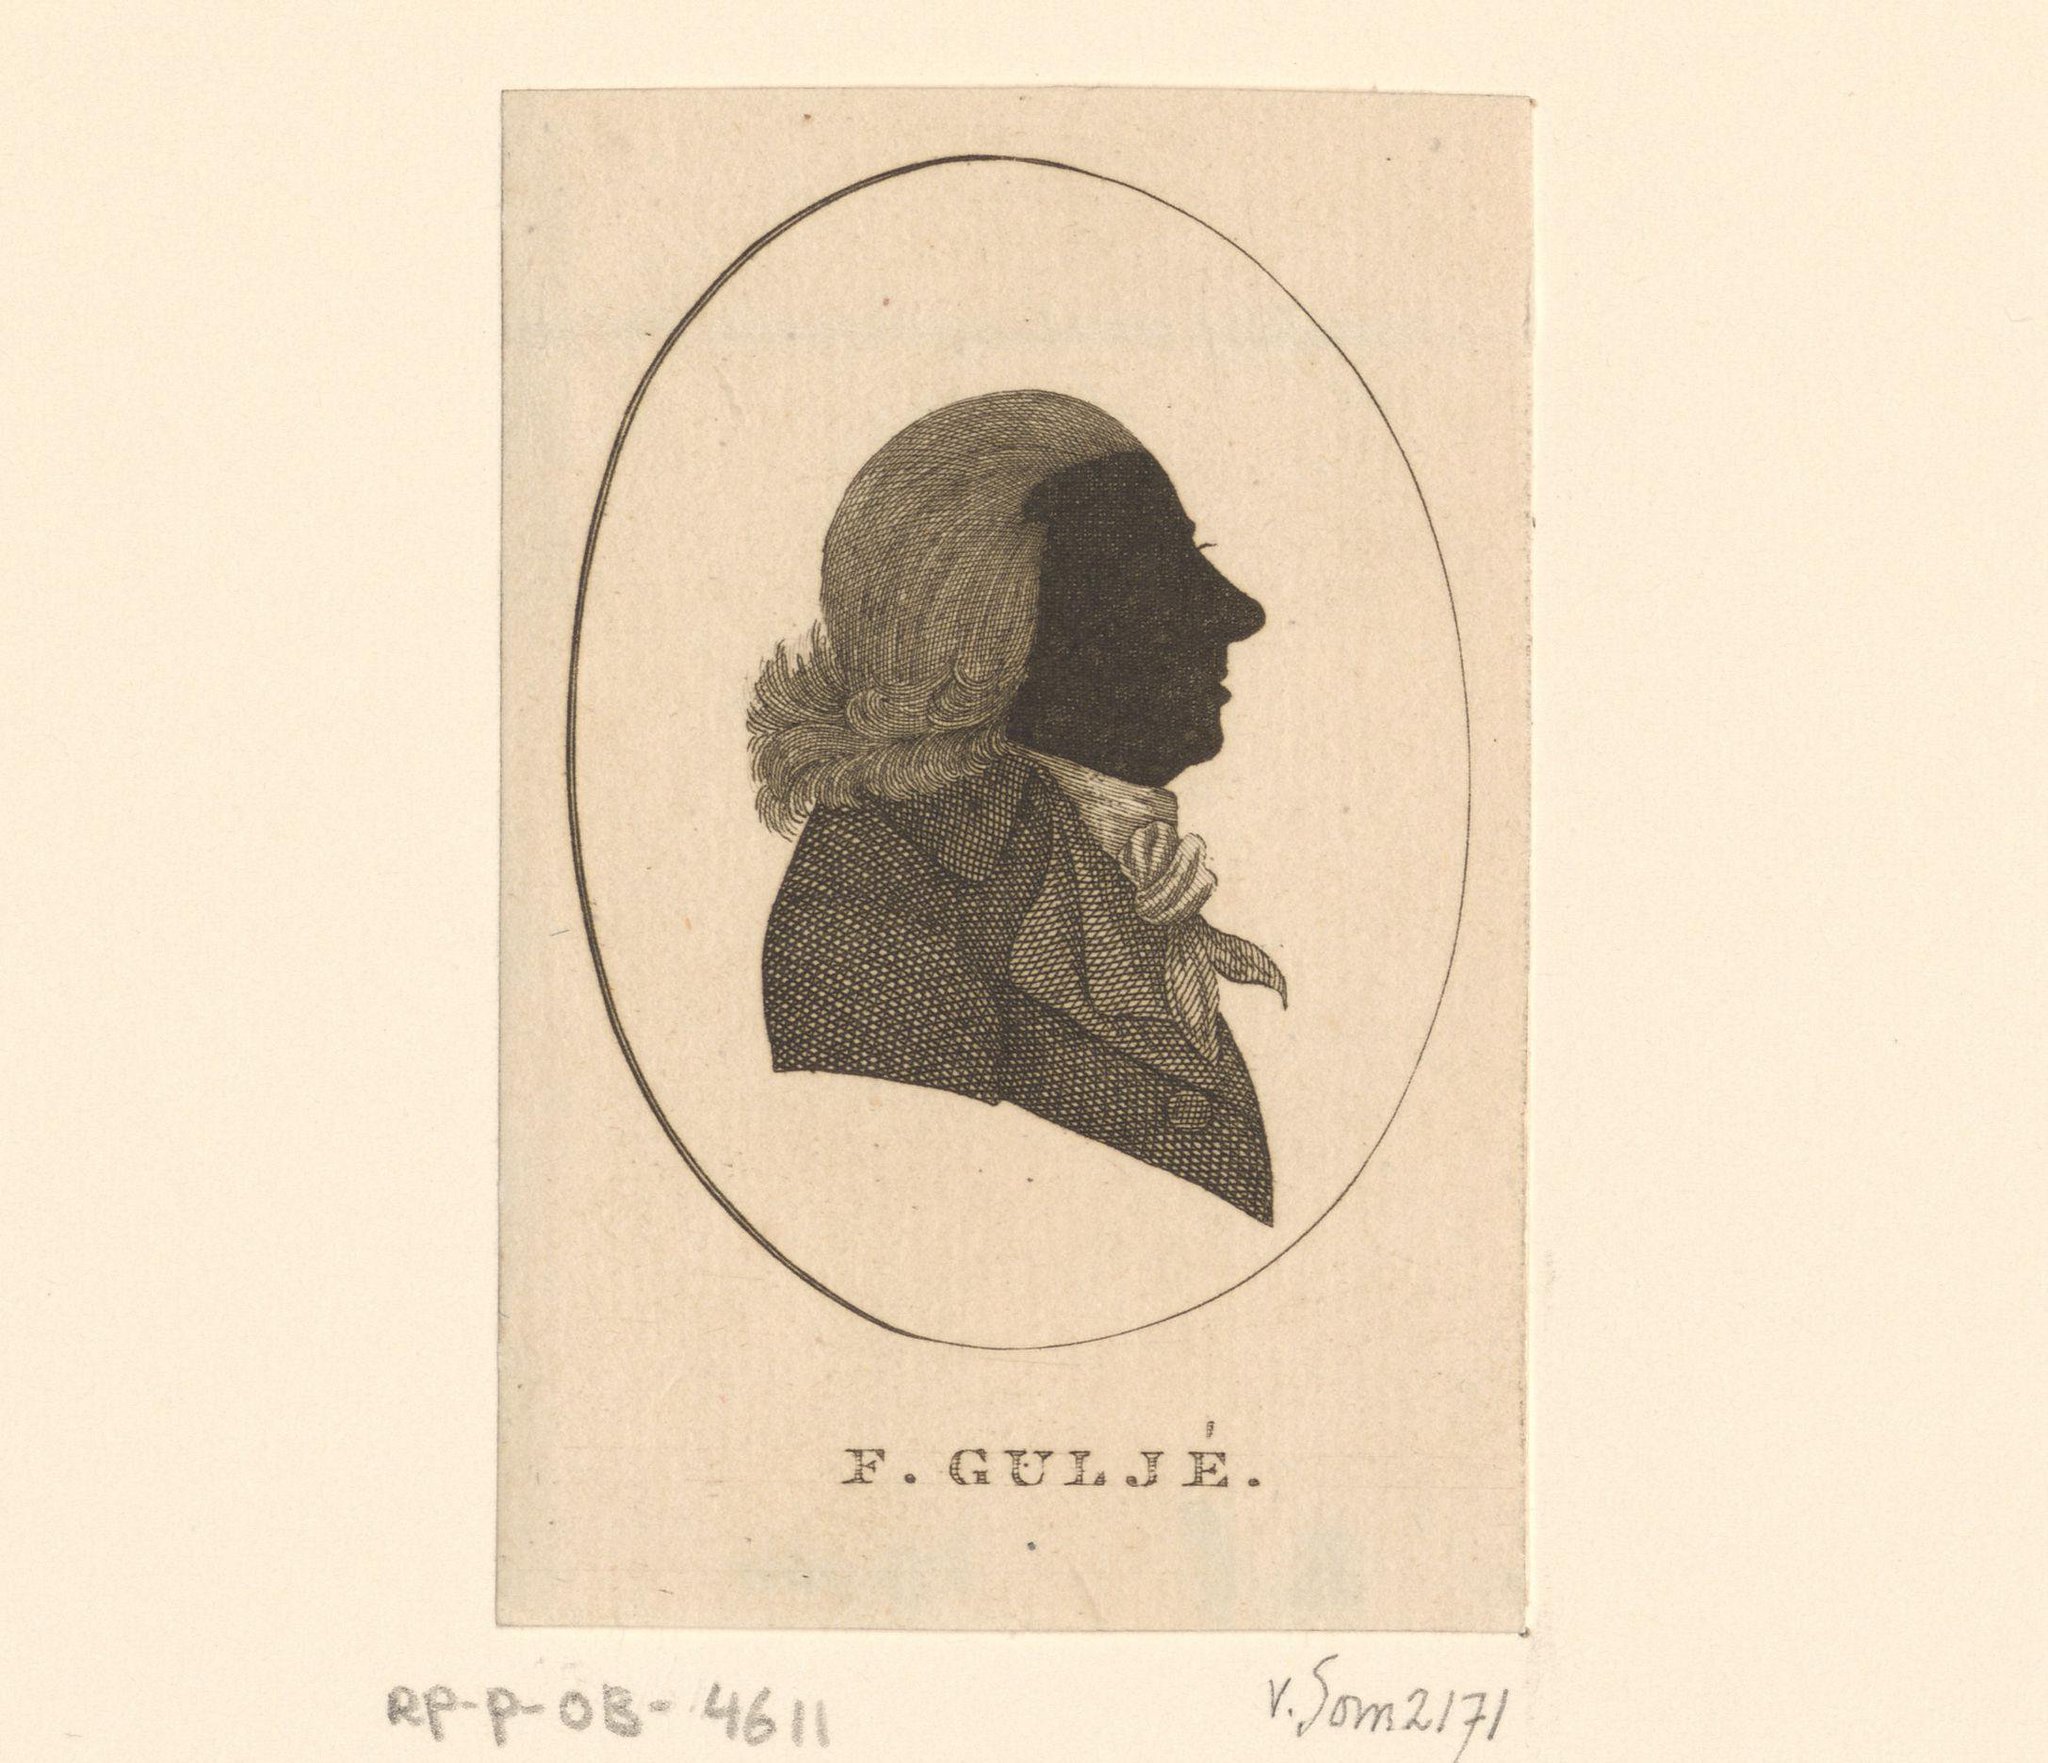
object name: book illustration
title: Portret van Petrus Franciscus Guljé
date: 1799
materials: paper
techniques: engraving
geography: amsterdam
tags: historical persons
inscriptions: collector's mark: Lugt 2228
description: Prent waarschijnlijk gemaakt naar een ontwerp door Hausdorff voor de serie 'Representanten van de eerste Nationale Vergadering van de Bataafse Republiek' uit 1796. Prent uit: Rogge, Cornelis. Geschiedenis der staatsregeling, voor het Bataafsche volk. Amsterdam: Johannes Allart, 1799.